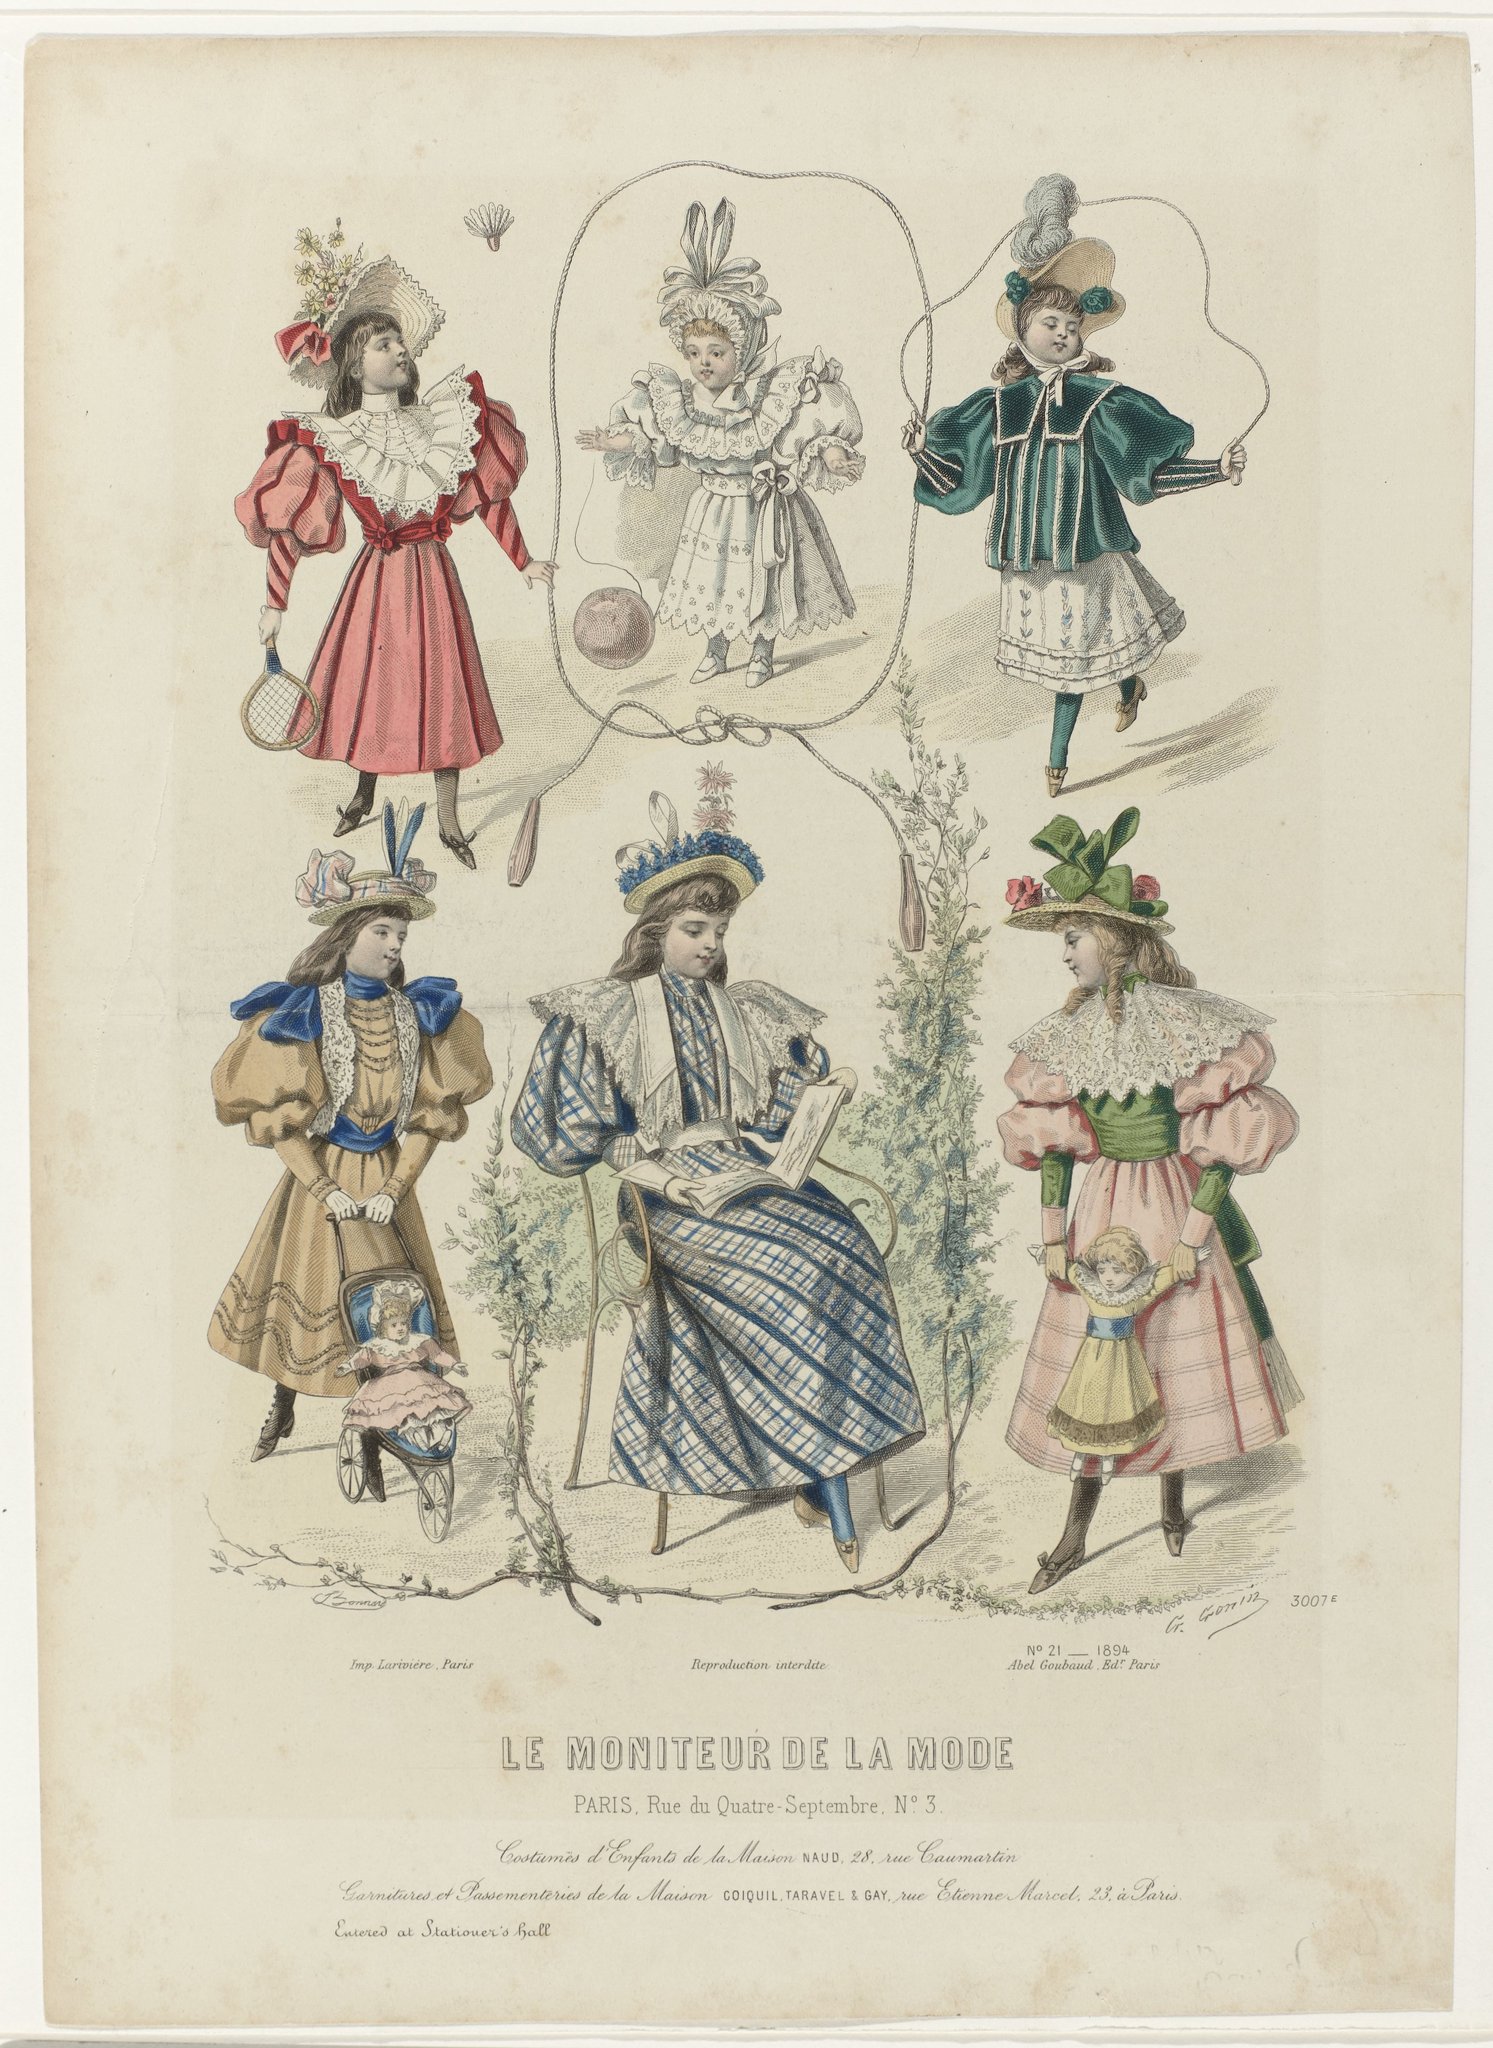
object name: fashion print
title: Le Moniteur de la Mode, 1894, Nr. 3007e, No. 21: Costumes d'Enfants (...)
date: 1894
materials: paper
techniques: engraving, hand coloring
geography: paris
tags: reading, head-gear: hat (+ girls' clothes), neck-gear: collar (+ girls' clothes), (playing with) dolls (+ equipment, outfit (sports, games, etc.)), 'jeu de volant', badminton, fashion plates, book - mm - book open, jumping-rope games, dress, gown (+ girls' clothes)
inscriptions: address: ‘Paris, Rue du Quatre-Septembre, No. 3’, caption: ‘Costumes d'Enfants de la Maison NAUD, 28, rue Caumartin Garnitures et Passementeries de la Maison COIQUIL, TARAVEL & GAY, rue Etienne Marcel, 23, à Paris. / Entered at Stationer's hall’, title: ‘LE MONITEUR DE LA MODE’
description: Zes meisjes van verschillende leeftijden in kaders, spelend met badmintonracket en shuttle, bal, springtouw, boek, pop en poppen kinderwagen. Volgens het onderschrift: kinderkleding van Maison Naud. Hieronder enkele regels reclametekst voor verschillende producten. Prent uit het modetijdschrift Le Moniteur de la Mode (1843-1913).